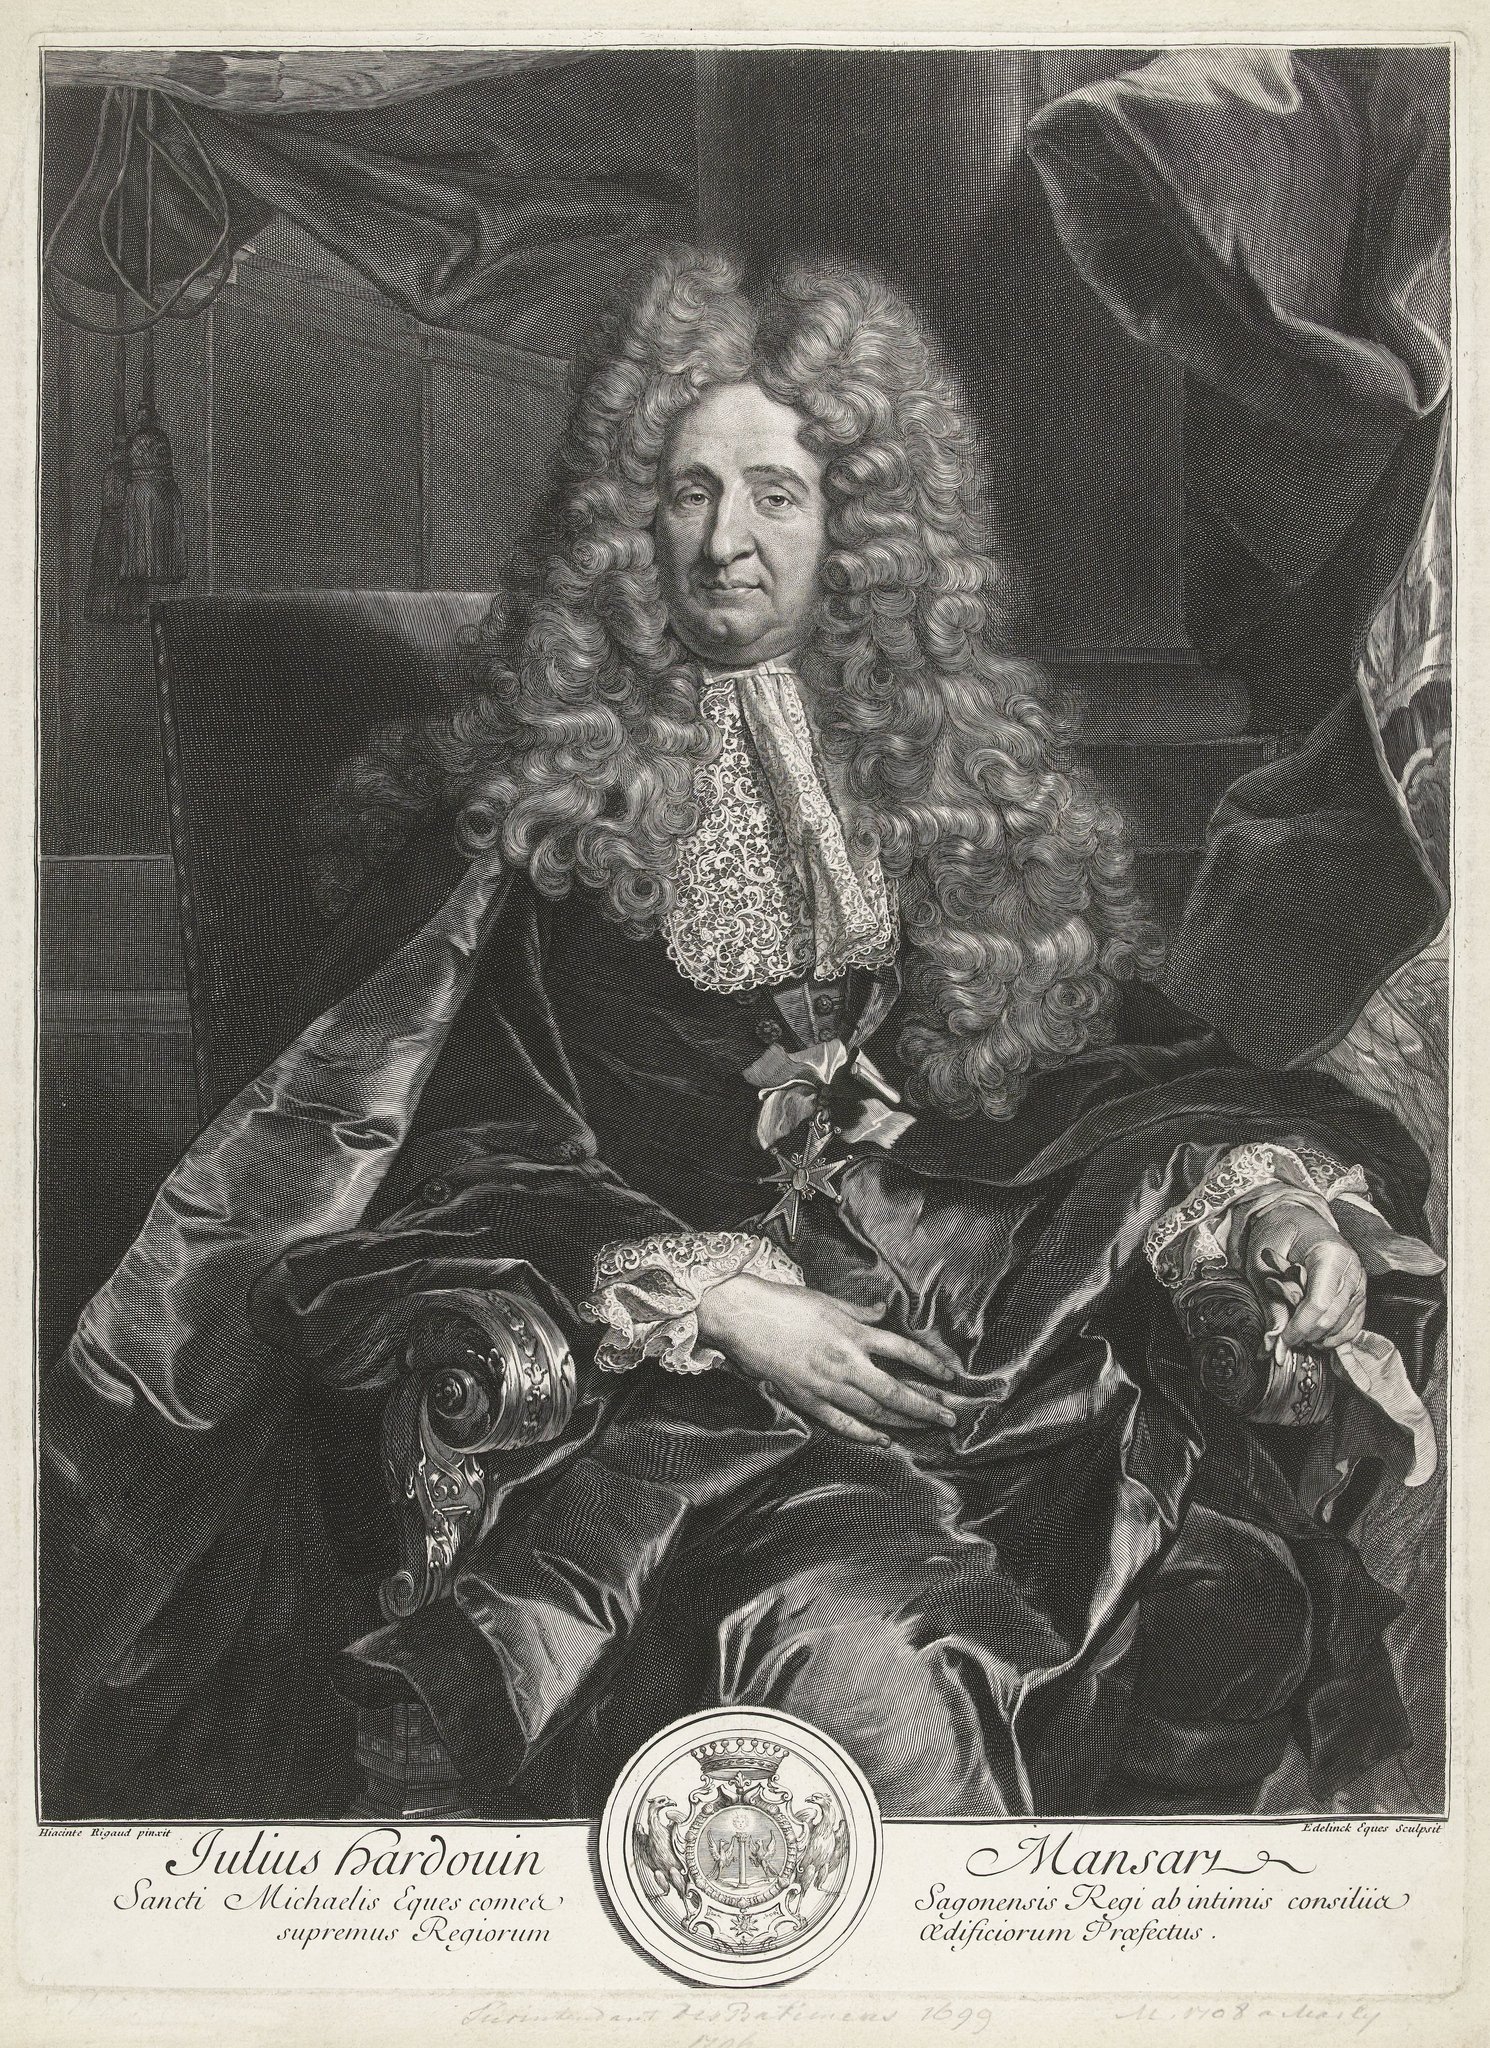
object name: print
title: Julius Hardouin Mansart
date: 1666-1707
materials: paper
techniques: engraving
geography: paris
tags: paris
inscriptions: collector's mark: Lugt 2228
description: De Franse architect Jules Hardouin-Mansart (1646-1708), afgebeeld zittend in stoel, met op de achtergrond een draperie en een pilaar. Onderaan een wapen en drie regels tekst in Latijn.